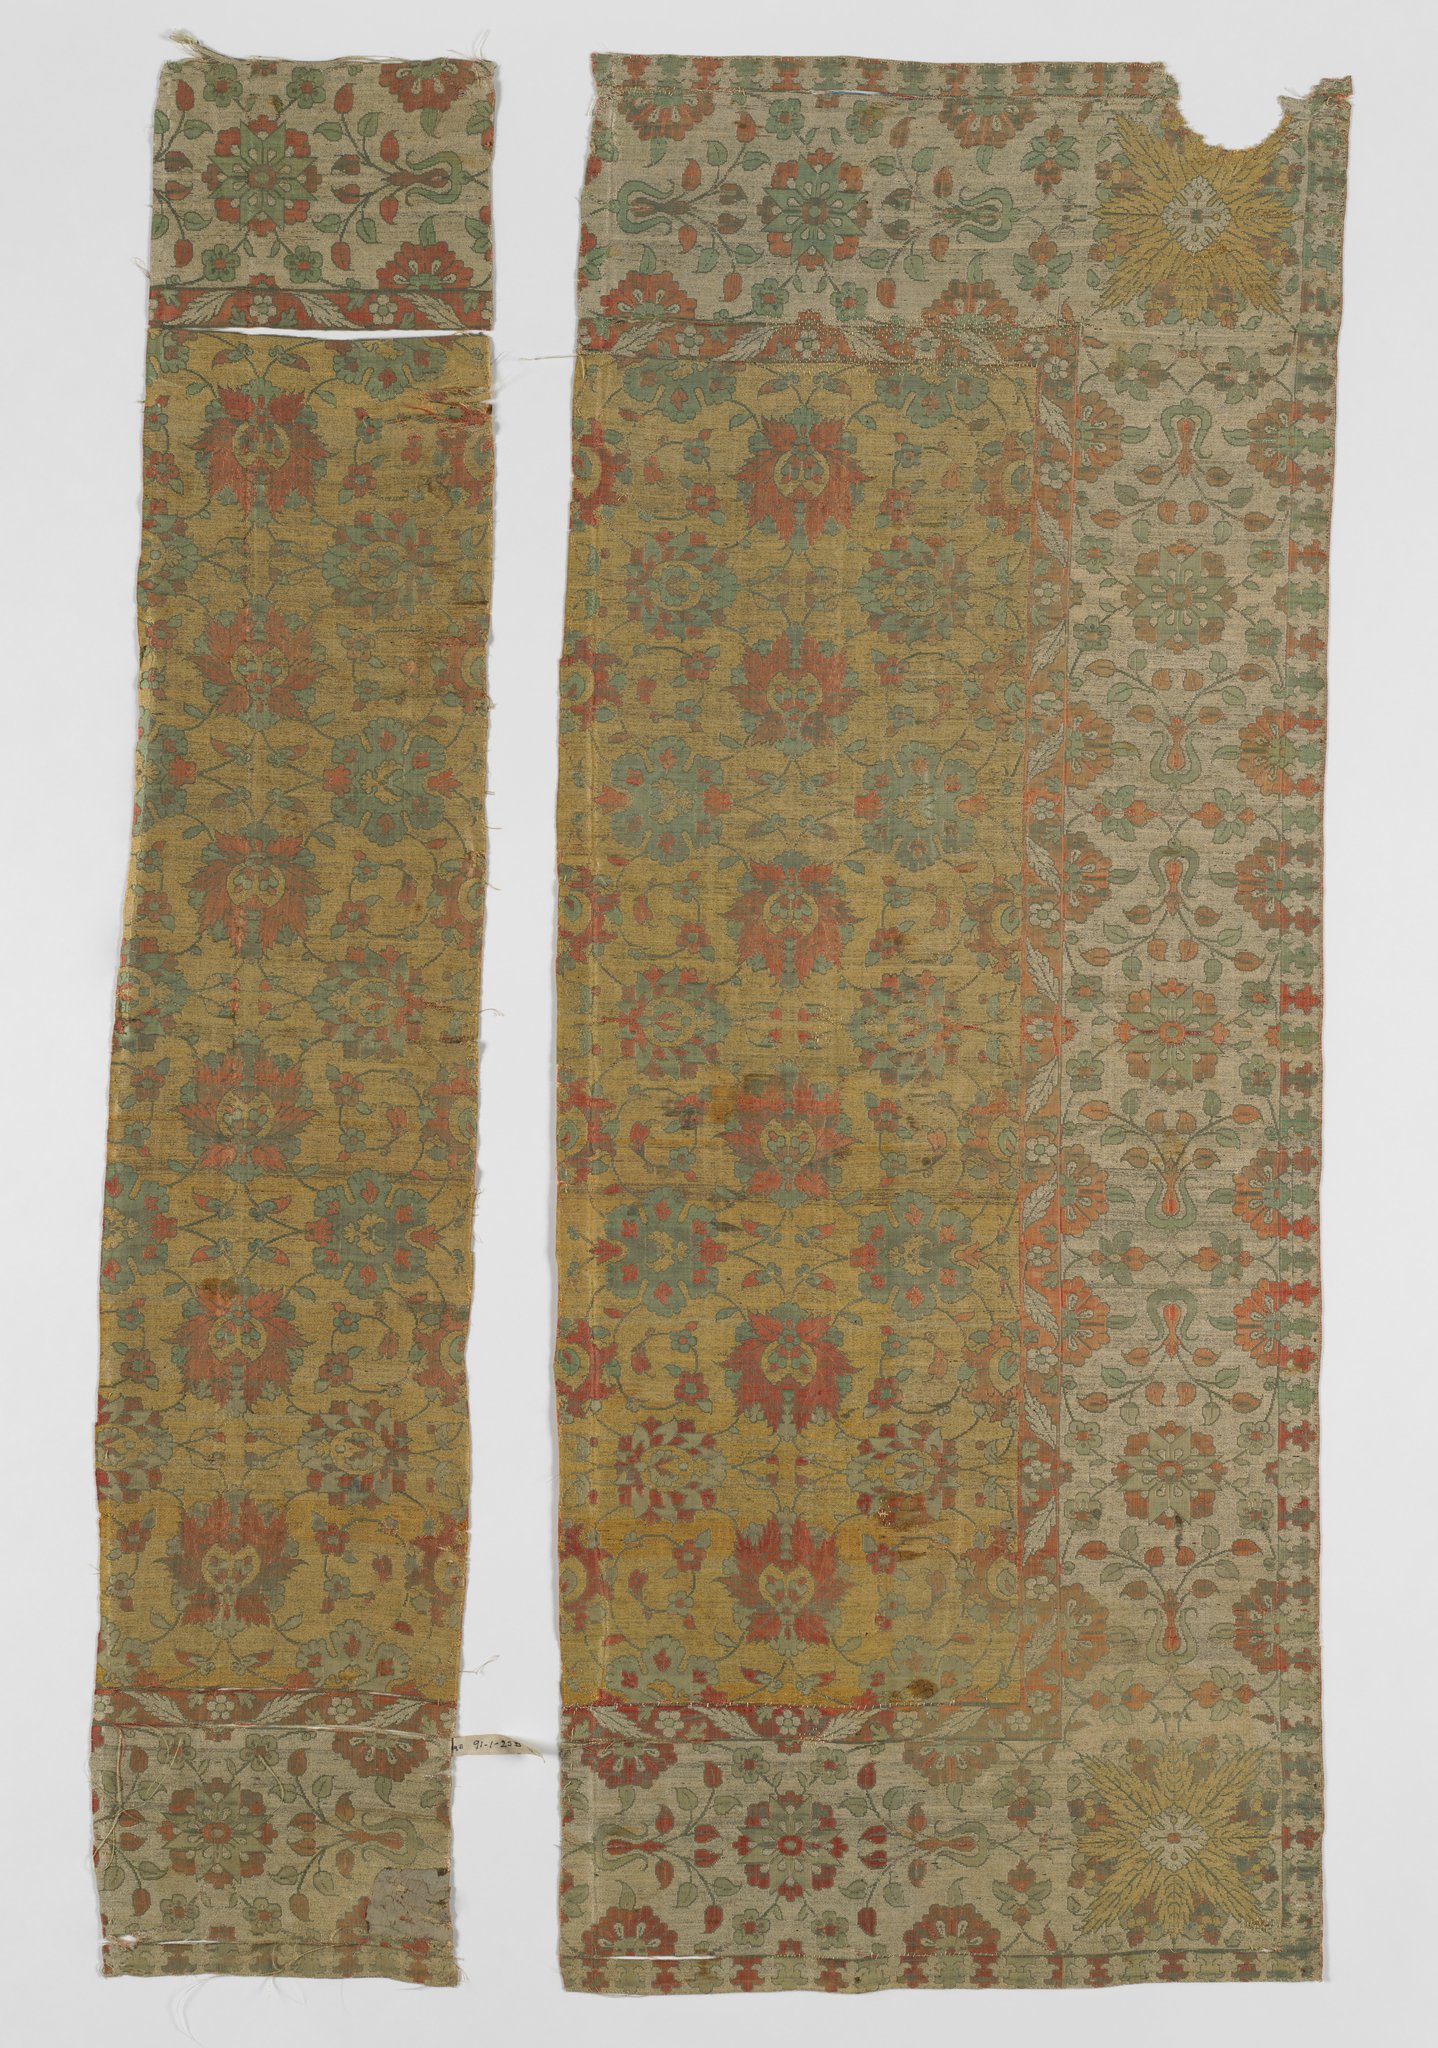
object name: textile fragment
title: Textile Fragments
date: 1667-1800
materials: metal thread, silk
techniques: lampas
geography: iran